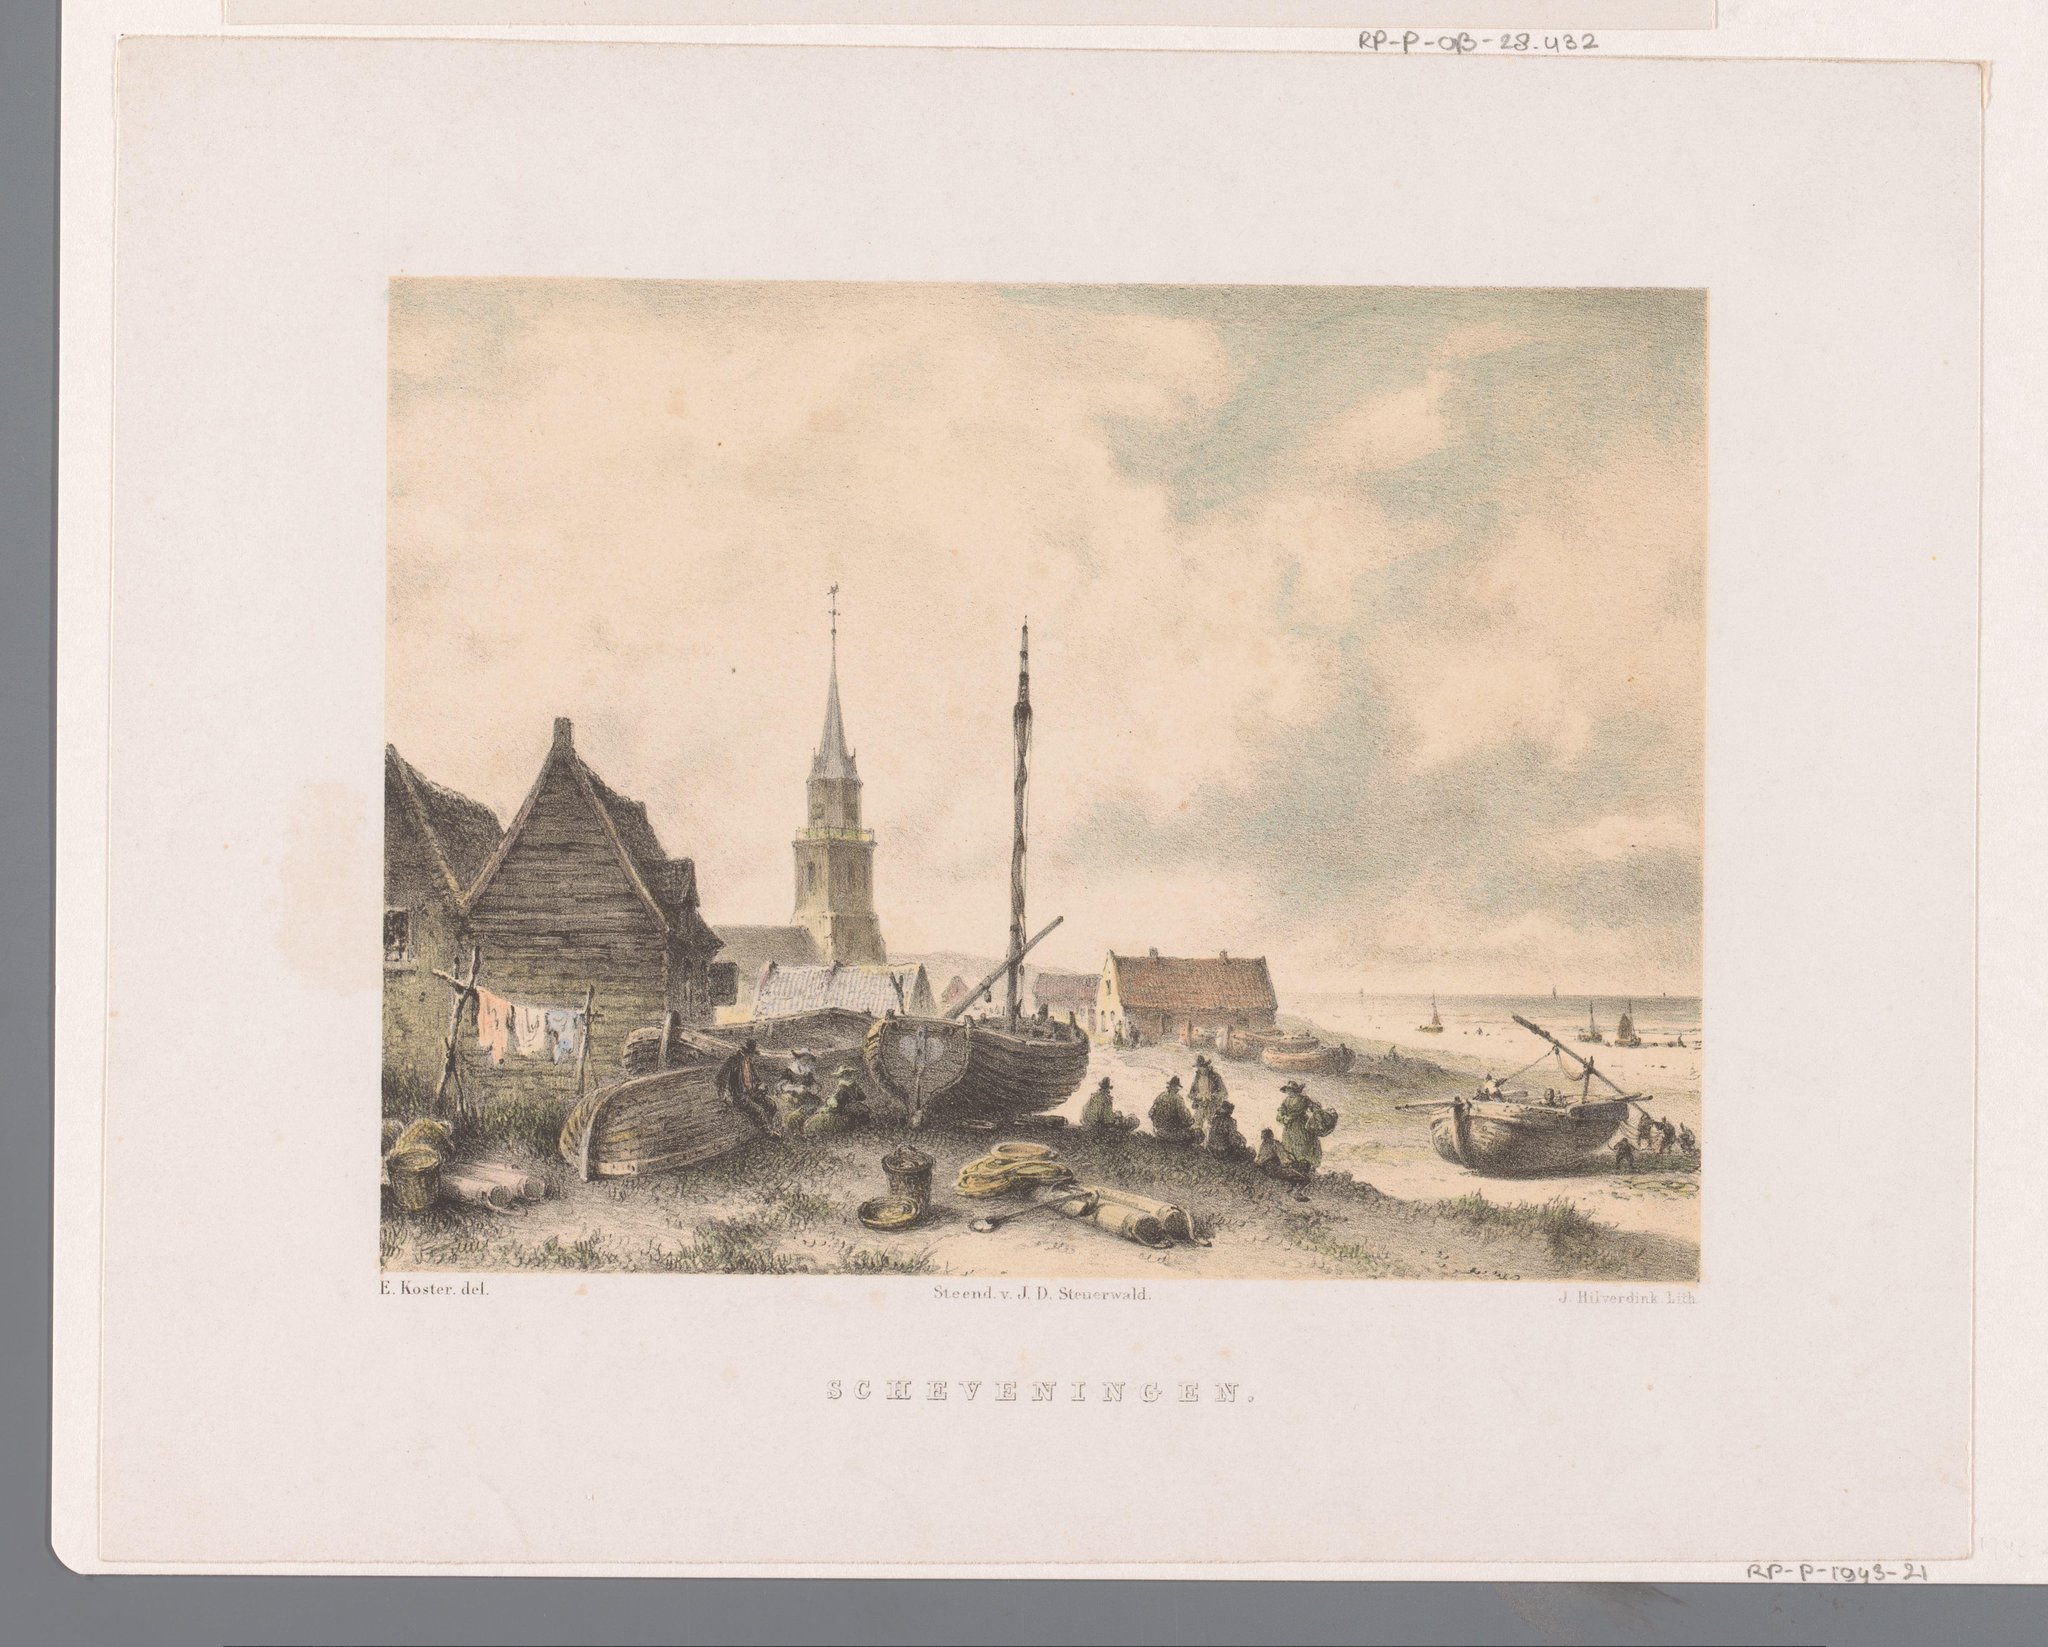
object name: print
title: Gezicht op het strand van Scheveningen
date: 1858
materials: paper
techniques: hand coloring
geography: amsterdam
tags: ships, boats on land, beached, beach (+ landscape with figures, staffage)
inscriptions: collector's mark: Lugt 2760, collector's mark: Lugt 2228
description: Deze prent komt uit: Koster, E. 'E. Koster's schetsboek: Nederlandsche Stads- en Havengezichten, uitgegeven onder medewerking van de maatschappij Arti et Amicitiae, Amsterdam, F. Buffa en Zn., e.a.' Amsterdam 1858.